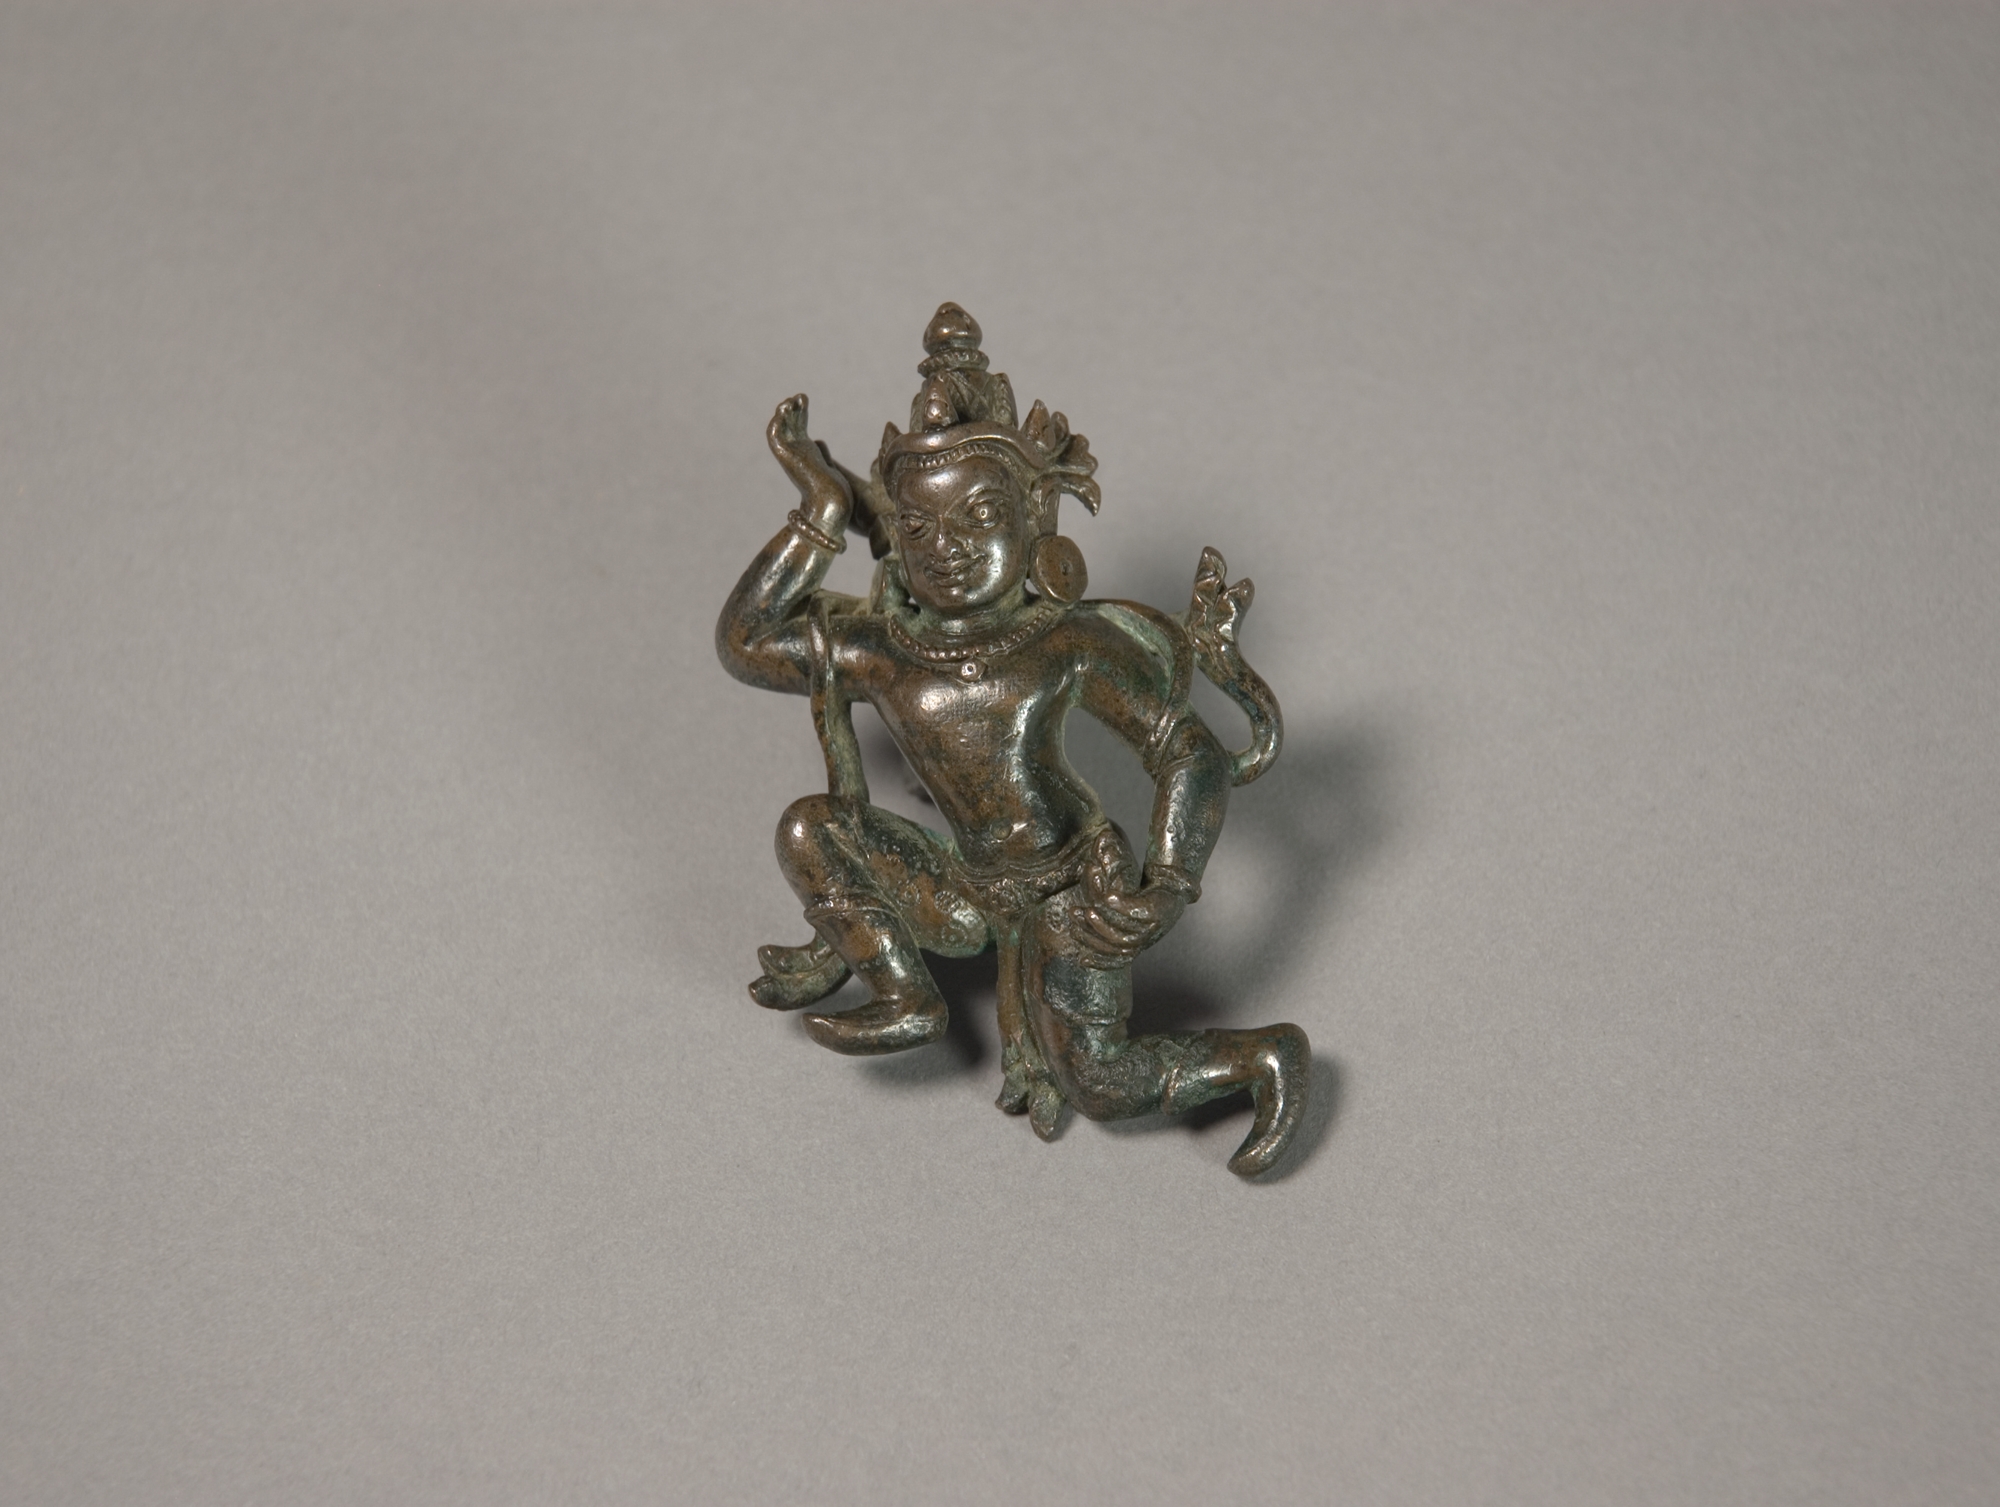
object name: figure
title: Celestial Attendant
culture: indian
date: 967-1000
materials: bronze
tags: deities